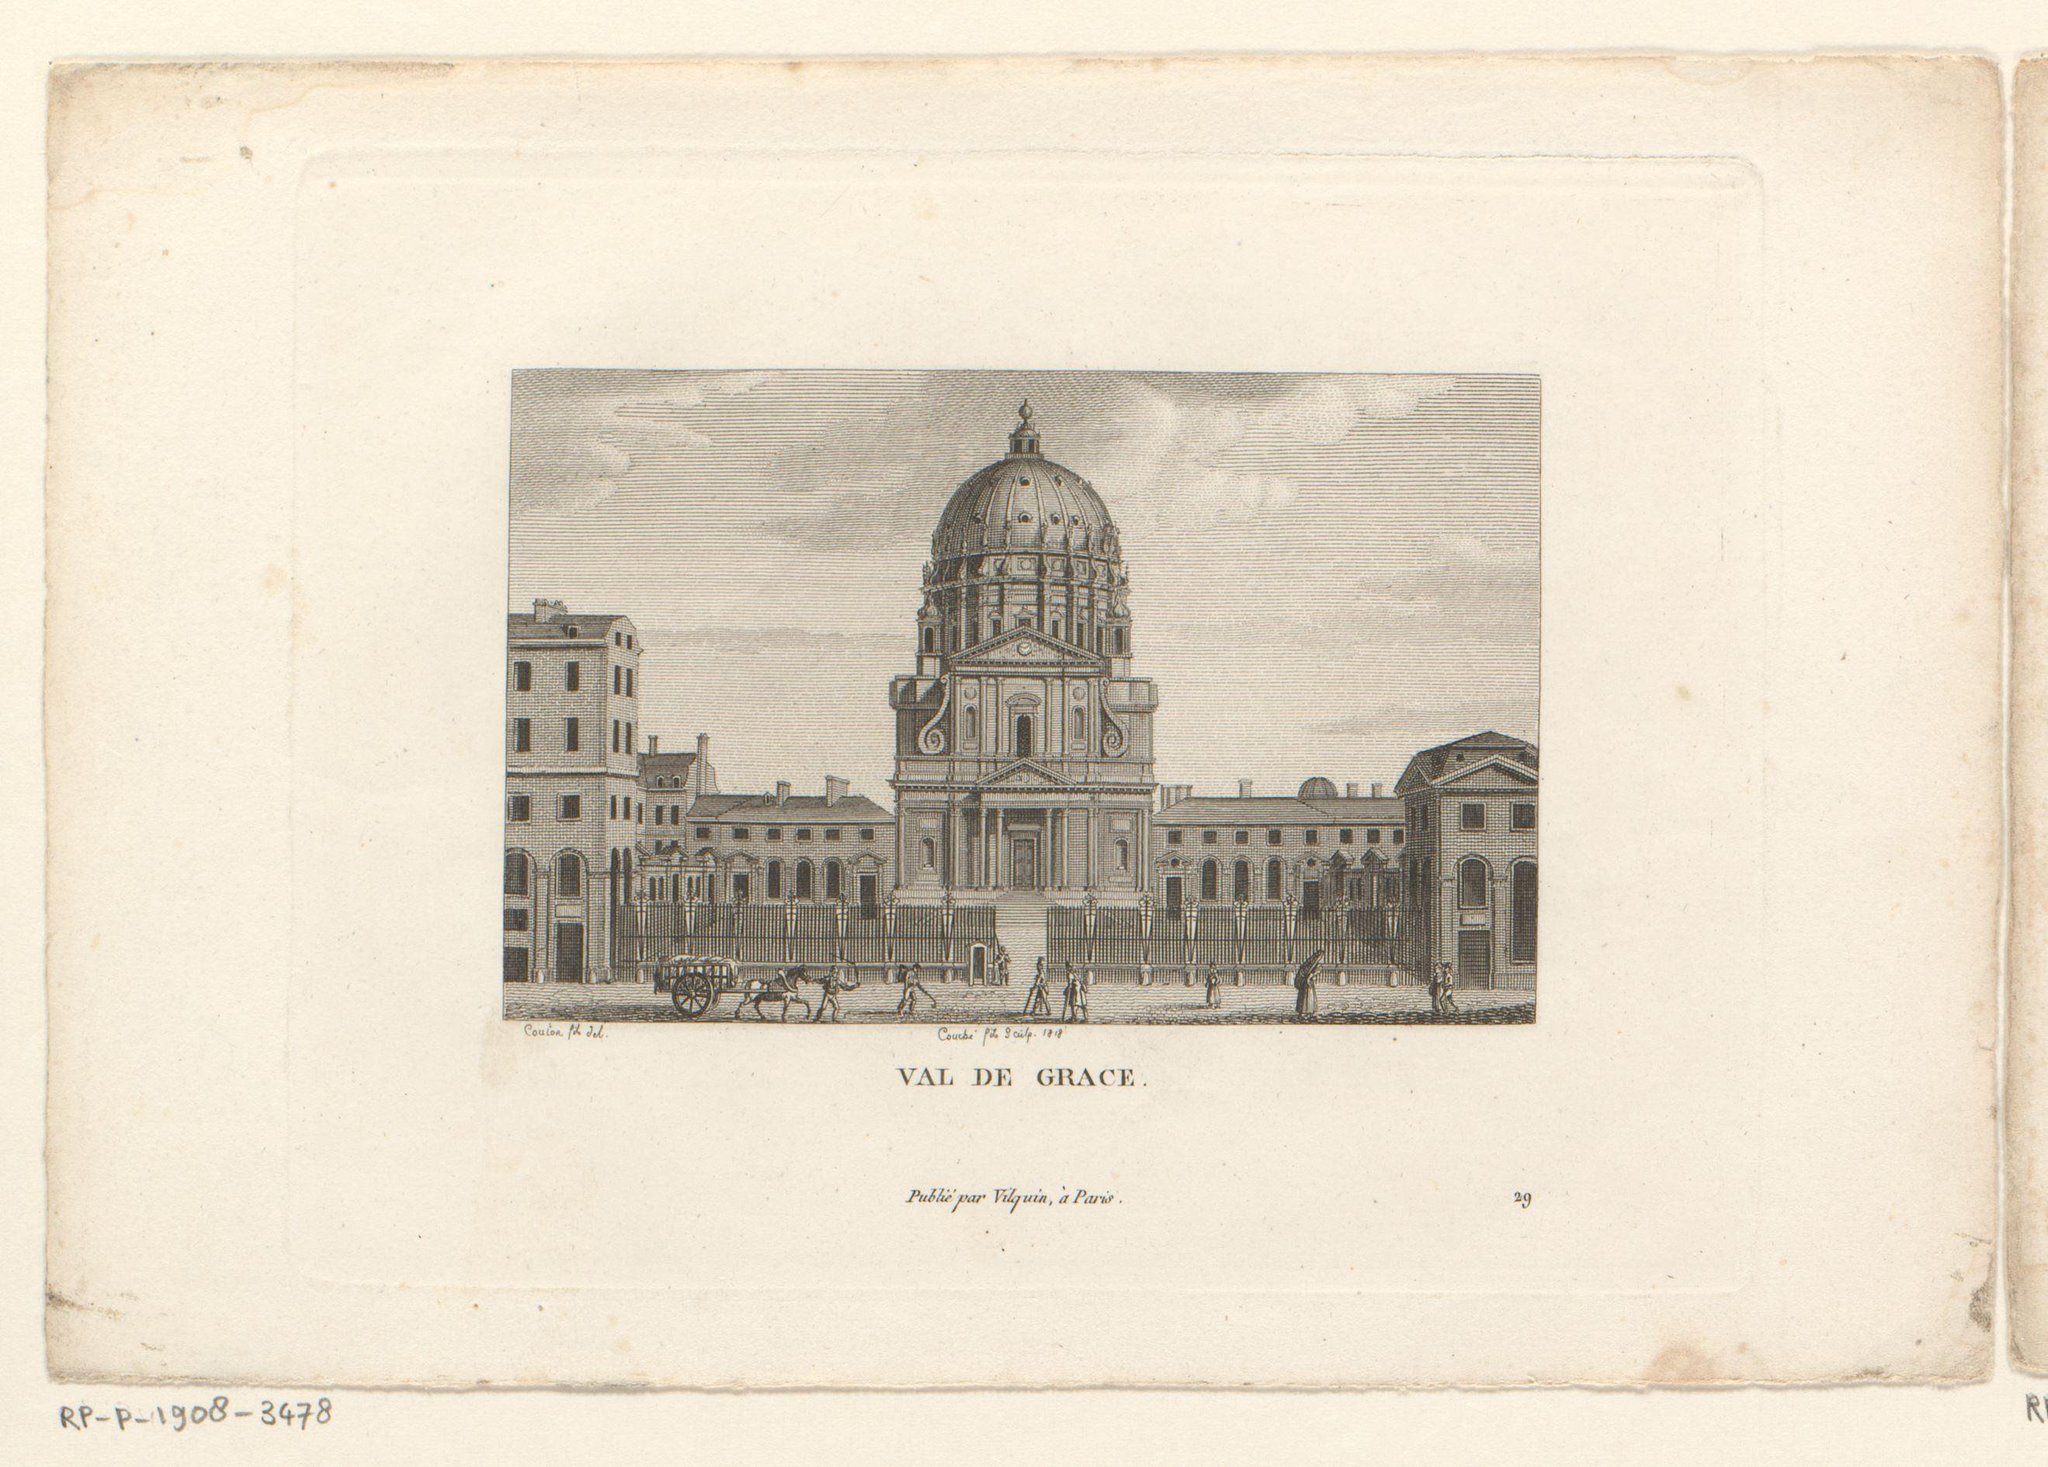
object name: print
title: Gezichten op Parijs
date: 1818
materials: paper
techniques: etching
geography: paris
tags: city-view in general; 'veduta', hospital, paris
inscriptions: collector's mark: Lugt 2228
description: Maakt deel uit van een serie met 60 platen van monumenten, kathedralen en paleizen in Parijs.